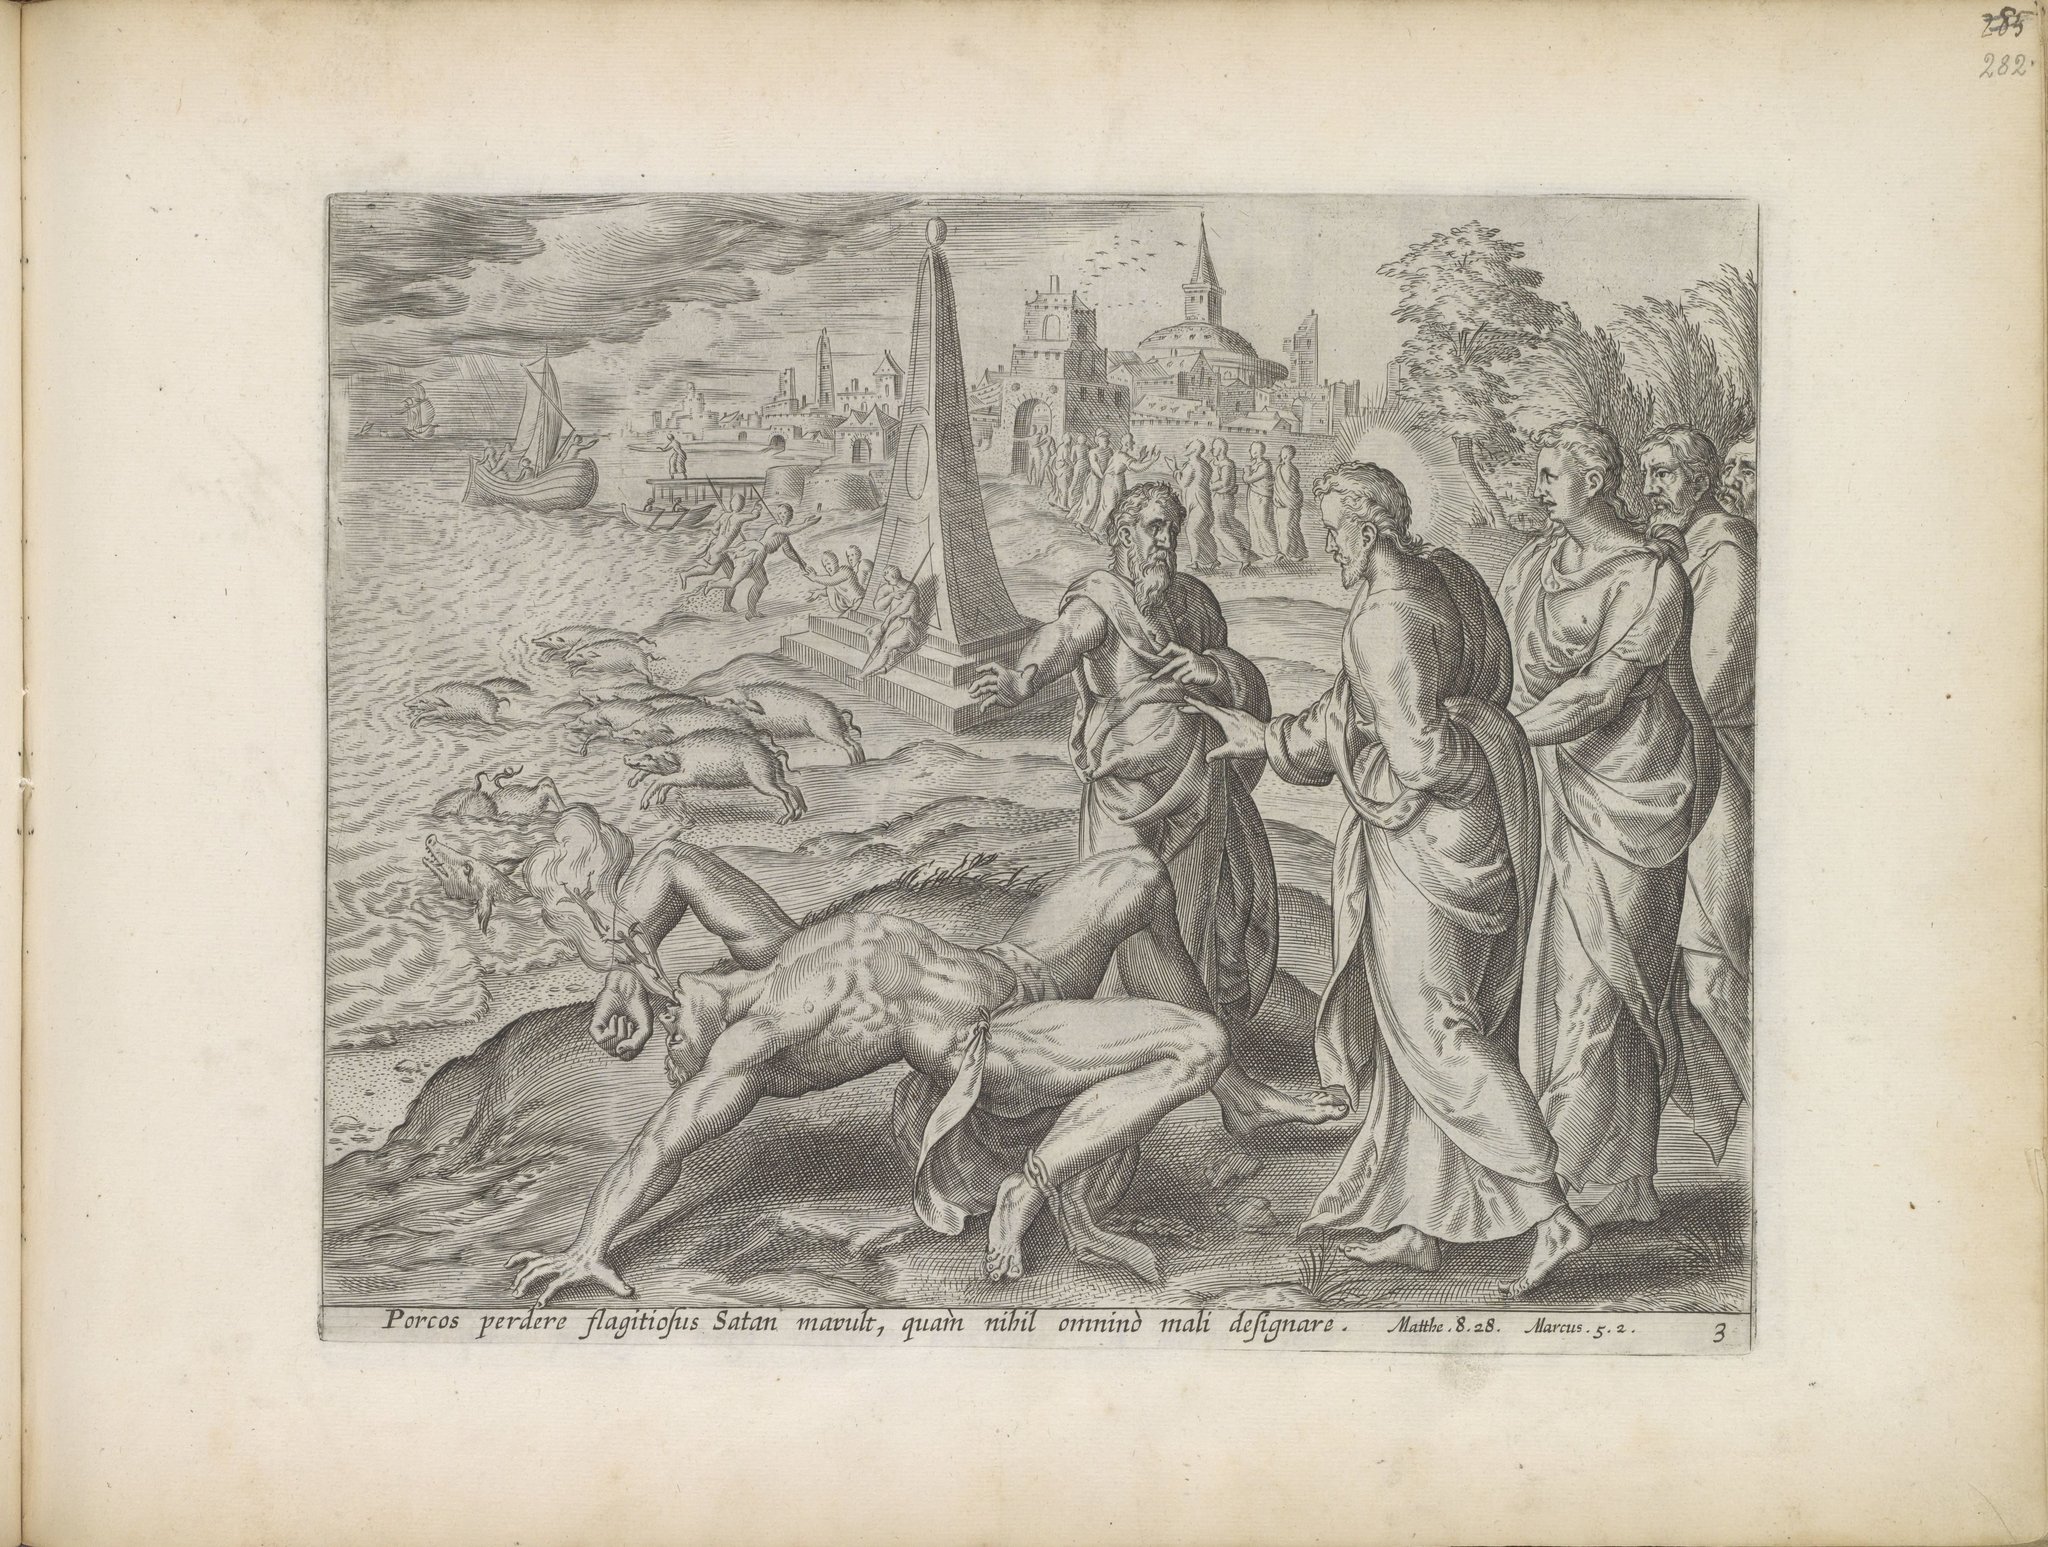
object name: album leaf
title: Christus geneest een bezeten man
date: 1572-1576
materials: paper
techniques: engraving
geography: amsterdam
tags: the demons enter into a herd of swine, which leap into the sea ~ healing of two possessed at gerasa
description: Christus geneest een bezeten man in het gebied van de Gerasenen. De onreine geesten verlaten de man via zijn mond en trekken in een kudde varkens, die het meer inrennen en verdrinken. De discipelen van Christus kijken toe. Op de achtergrond is het vervolg van het verhaal verbeeld: De varkenshoeders slaan op de vlucht en vertellen in de stad wat er is gebeurd. Daarop komen de bewoners naar Christus en vragen hem hun gebied te verlaten. Links op de achtergrond vertrekt Christus in een boot en blijft de genezen man achter op de steiger. Onder de voorstelling een verwijzing in het Latijn naar de Bijbeltekst in Mat. 8:28 en Mar. 5:2. Deze prent maakt deel uit van een album.